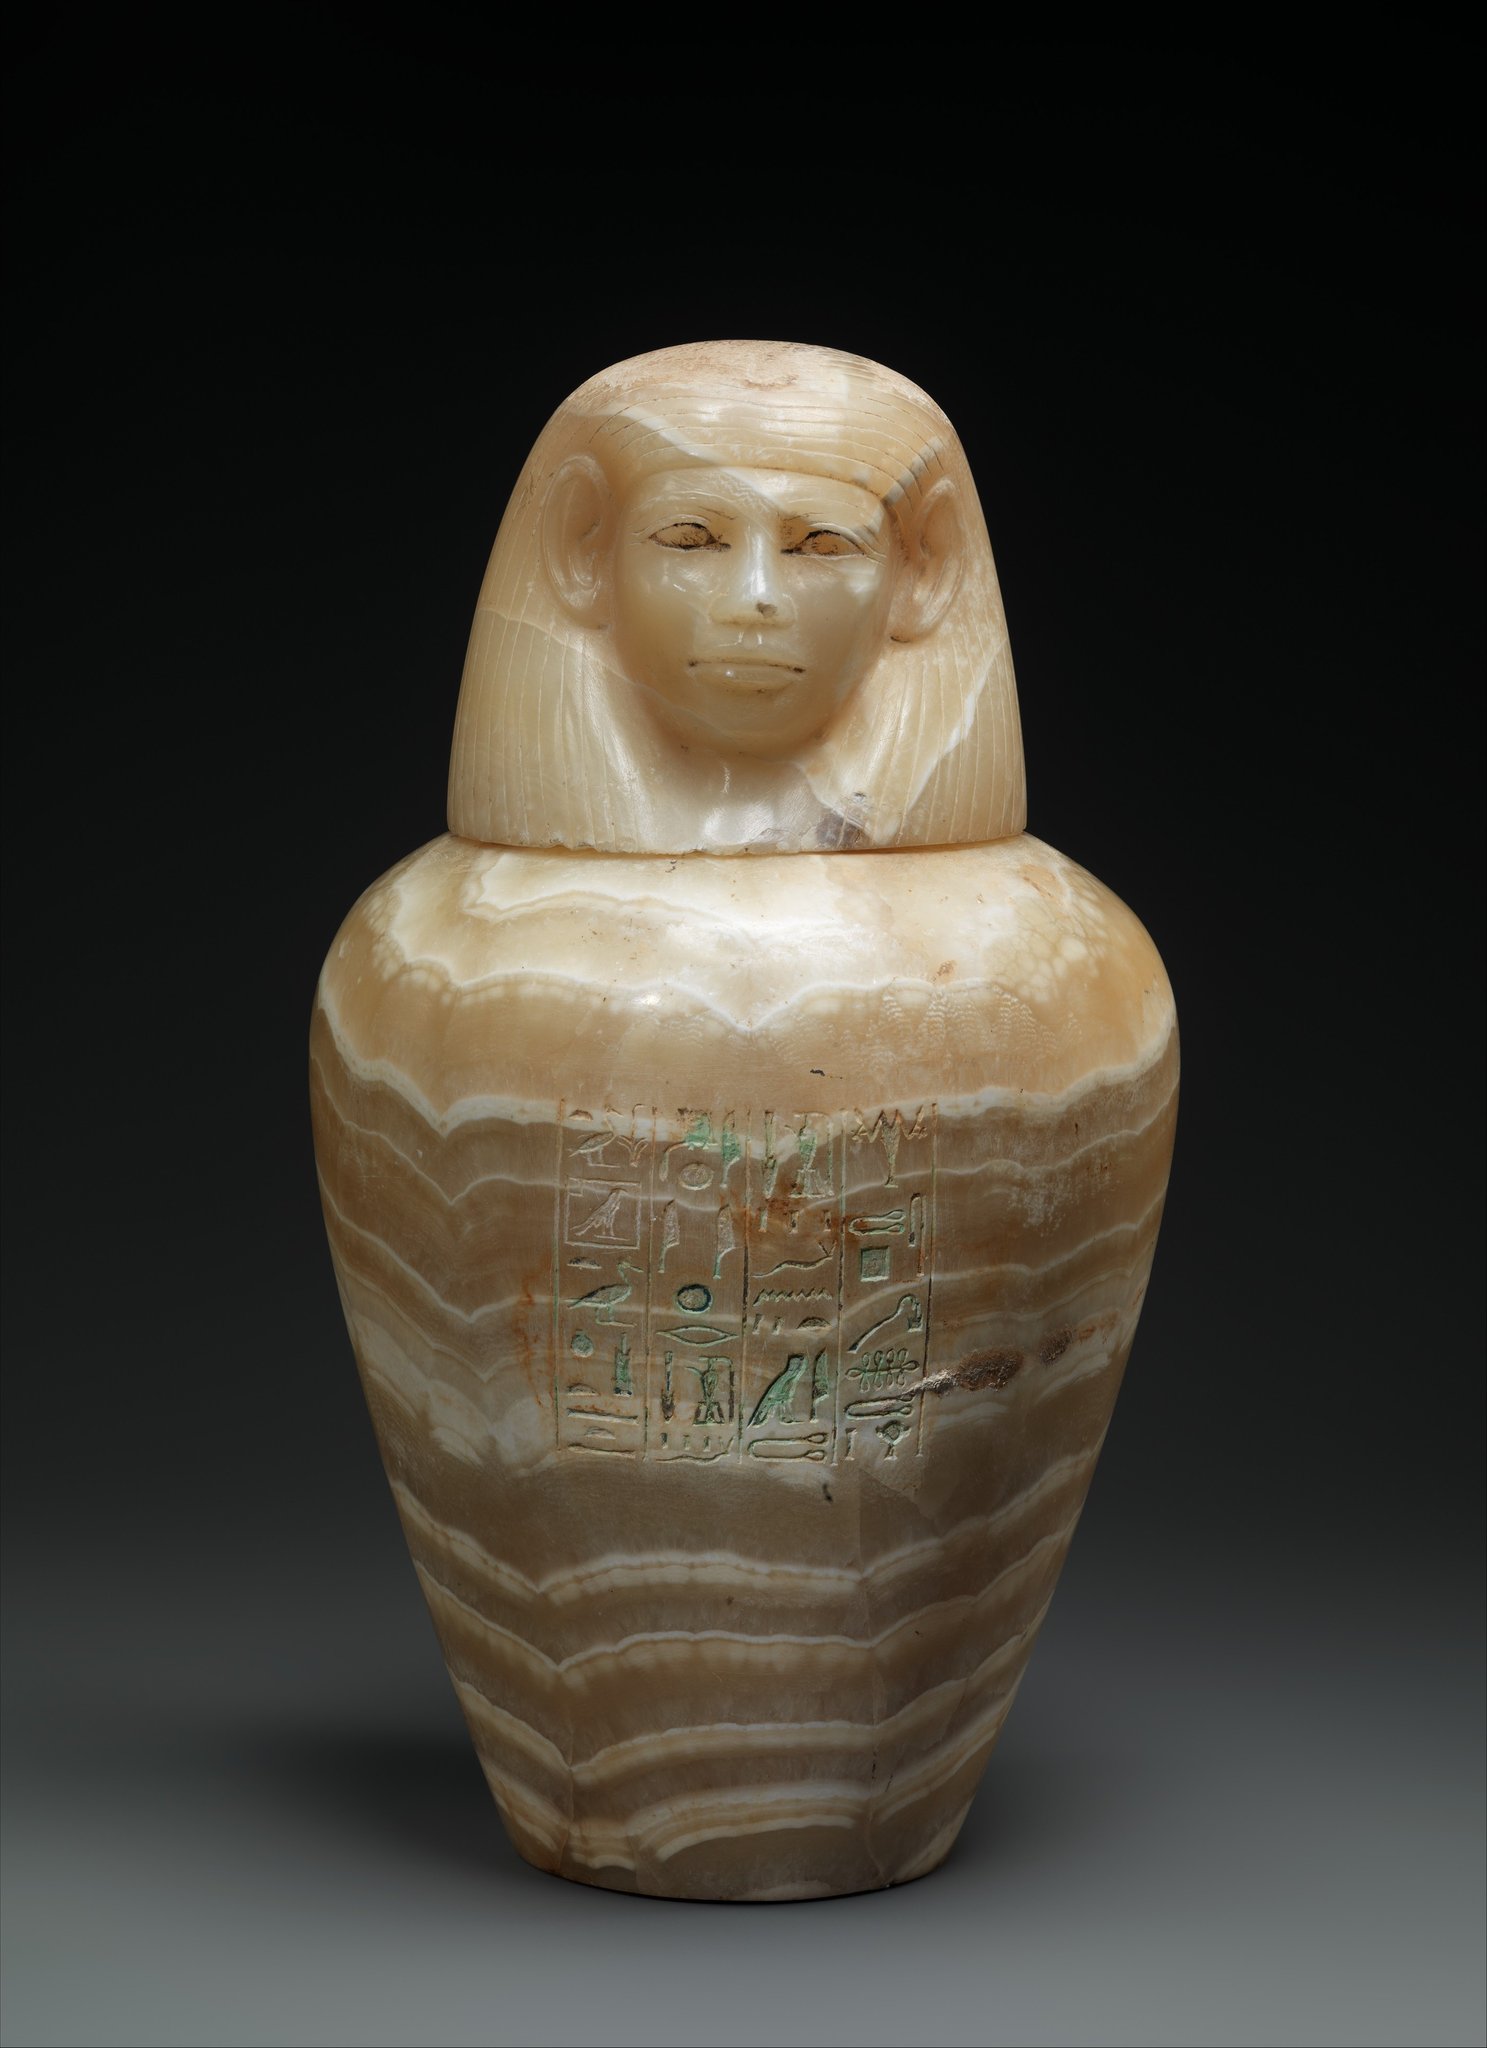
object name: canopic jar, sithathoryunet, qebehsenuef, selqet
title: Canopic Jar of Princess Sithathoryunet - Qebehsenuef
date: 1887-1813 BCE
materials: paint, stone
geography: egypt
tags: hieroglyphs